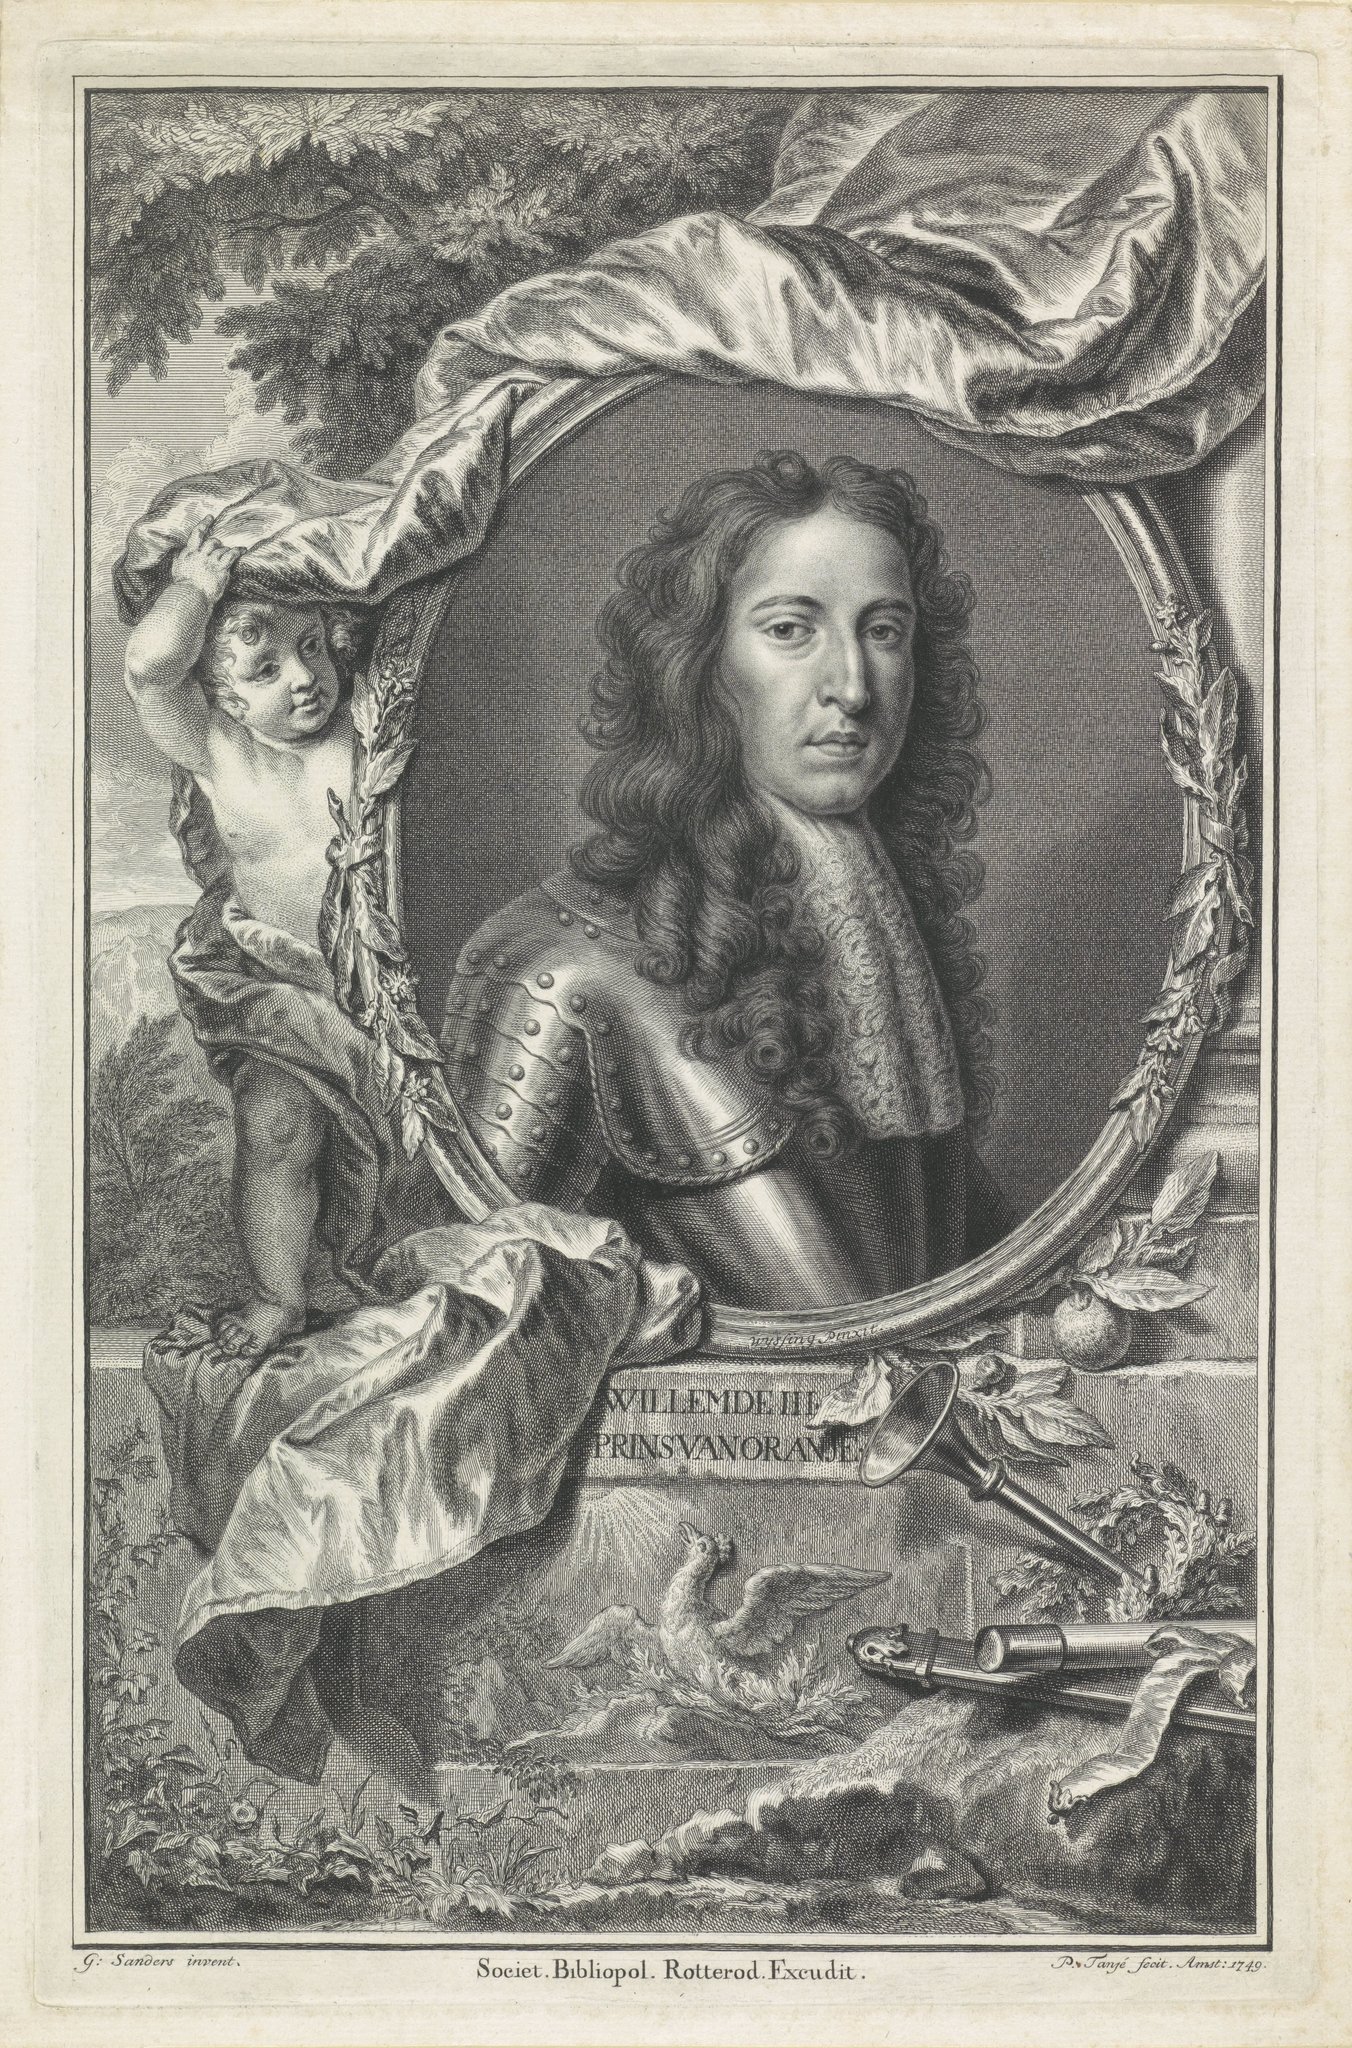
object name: print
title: Portret van Willem III, prins van Oranje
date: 1749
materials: paper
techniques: engraving, etching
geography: rotterdam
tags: the hague, william iii (prince of orange and king of england, scotland, and ireland)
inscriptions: date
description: Portret van Willem III in een ovaal. Rondom ligt een aantal allegorische objecten, waaronder een commandostaf, een lauwerkrans en een bazuin. Op het reliëf een verrijzende Phoenix en zijn naam.